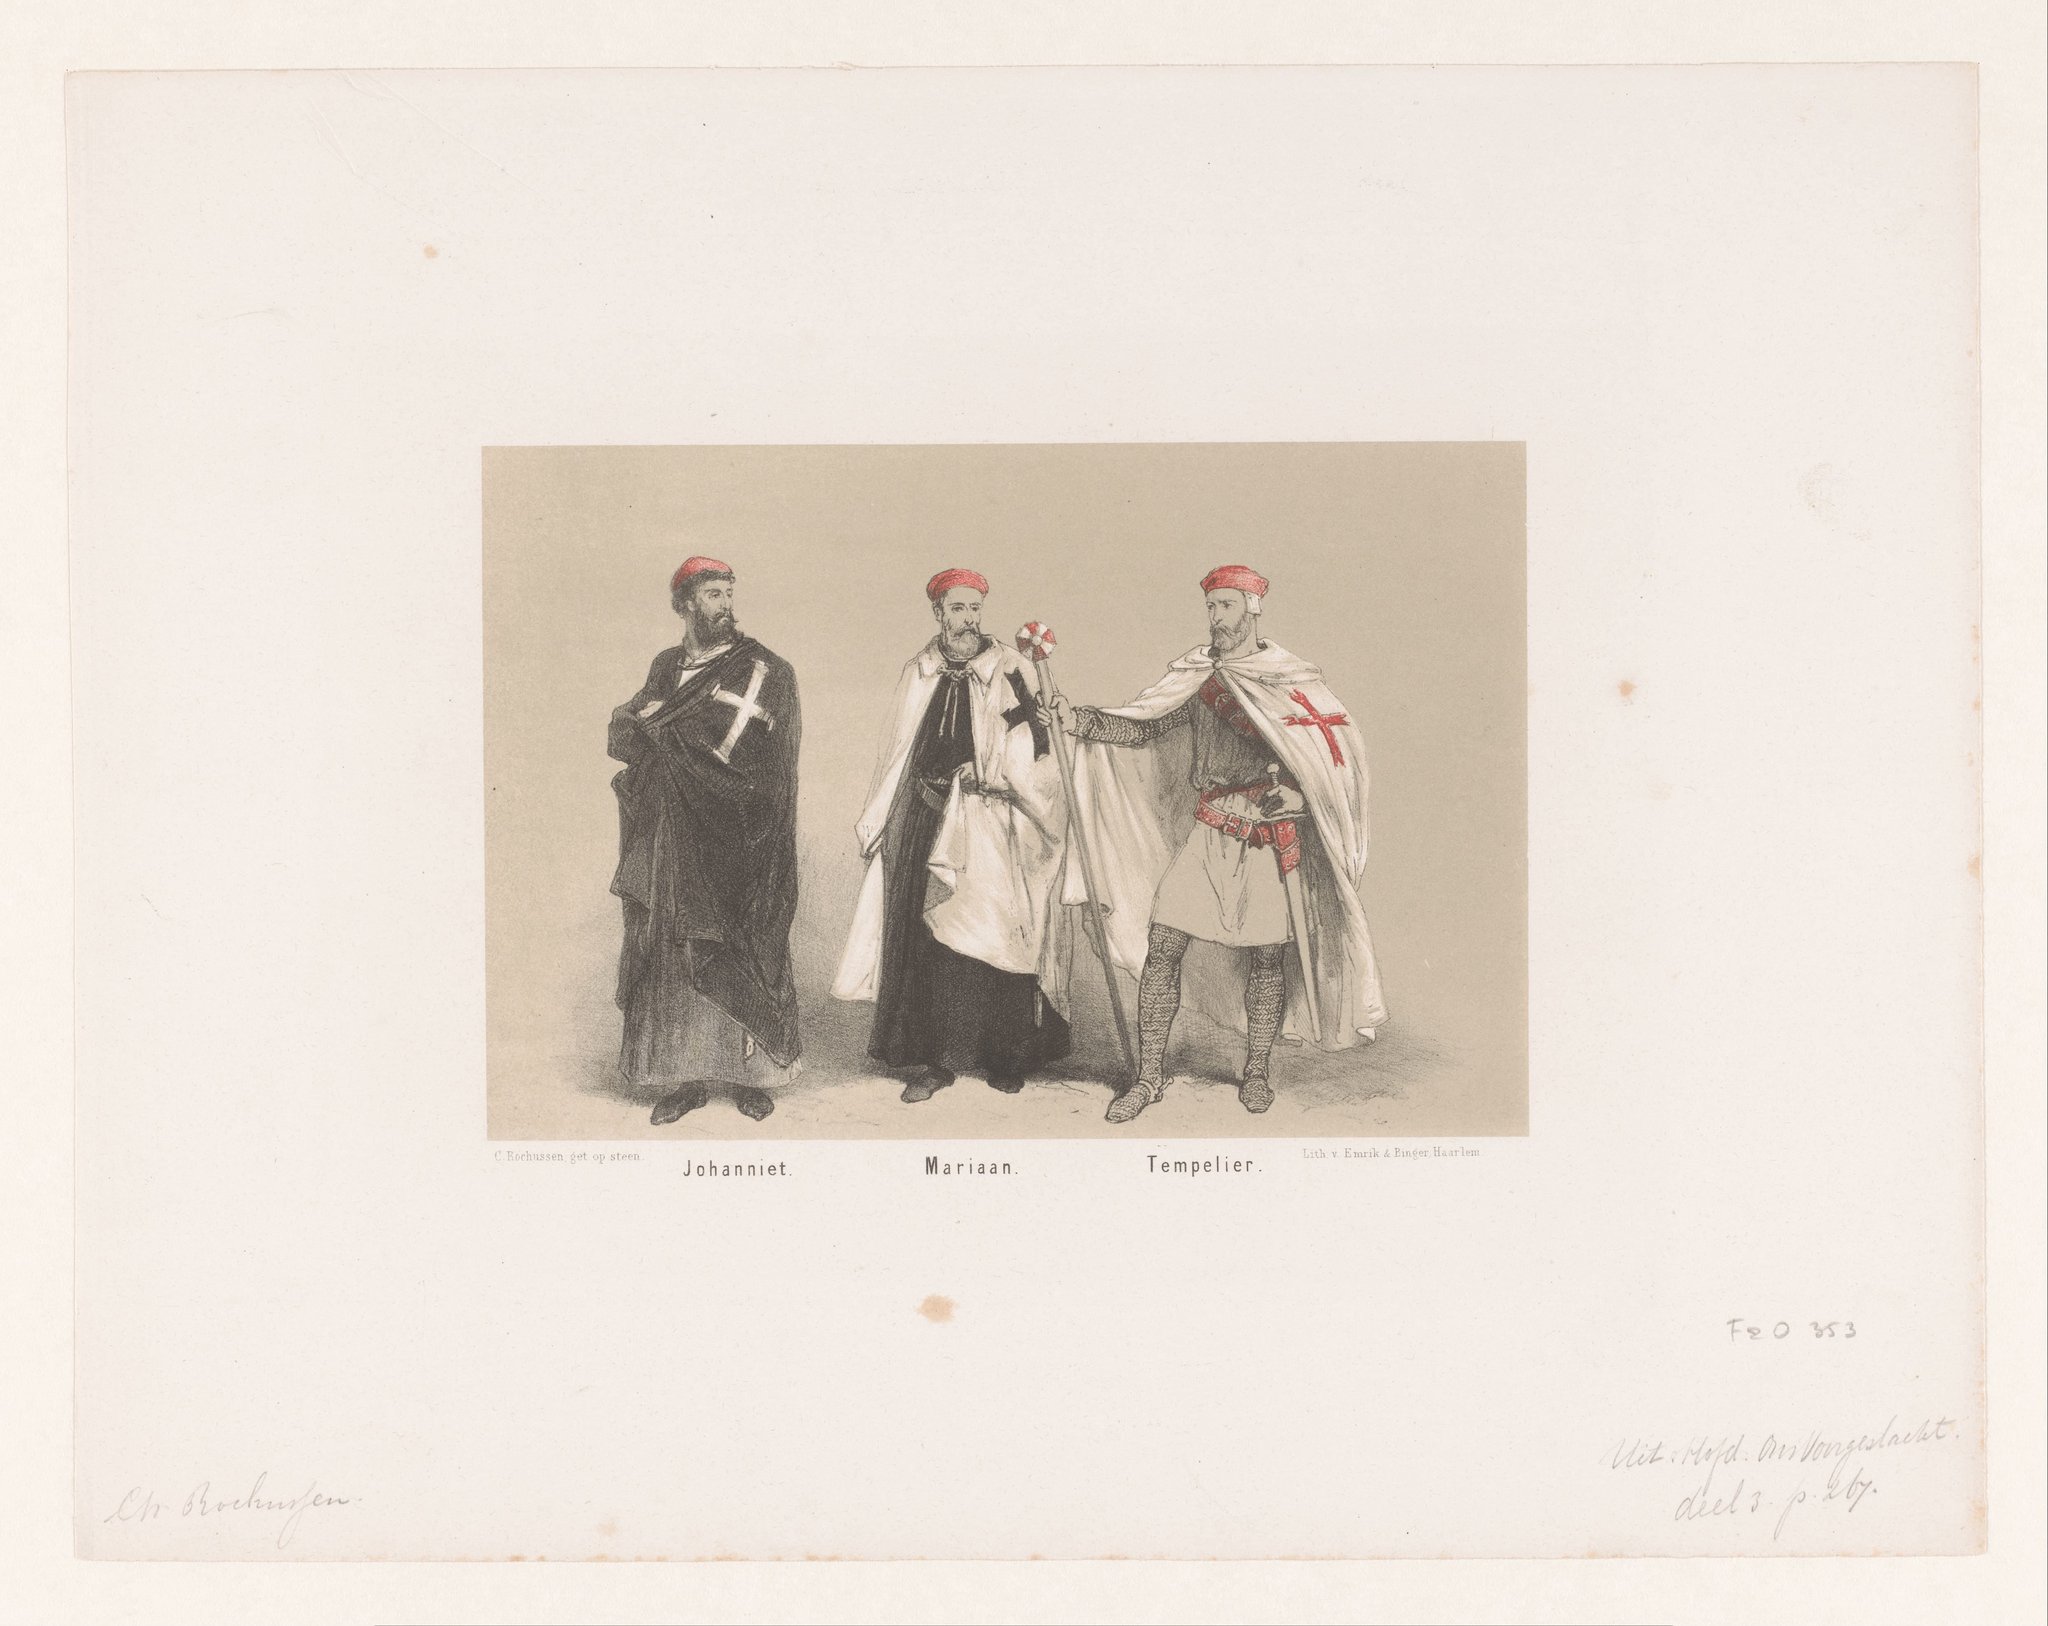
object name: print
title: Drie ridders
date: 1858-1864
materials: paper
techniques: tone lithography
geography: haarlem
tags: knighthood order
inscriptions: collector's mark: Lugt 2228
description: Prent uit: Hofdijk, W.F. Ons voorgeslacht in zijn dagelijksch leven geschilderd. Haarlem: Kruseman, Arie Cornelis, 1858-1864.